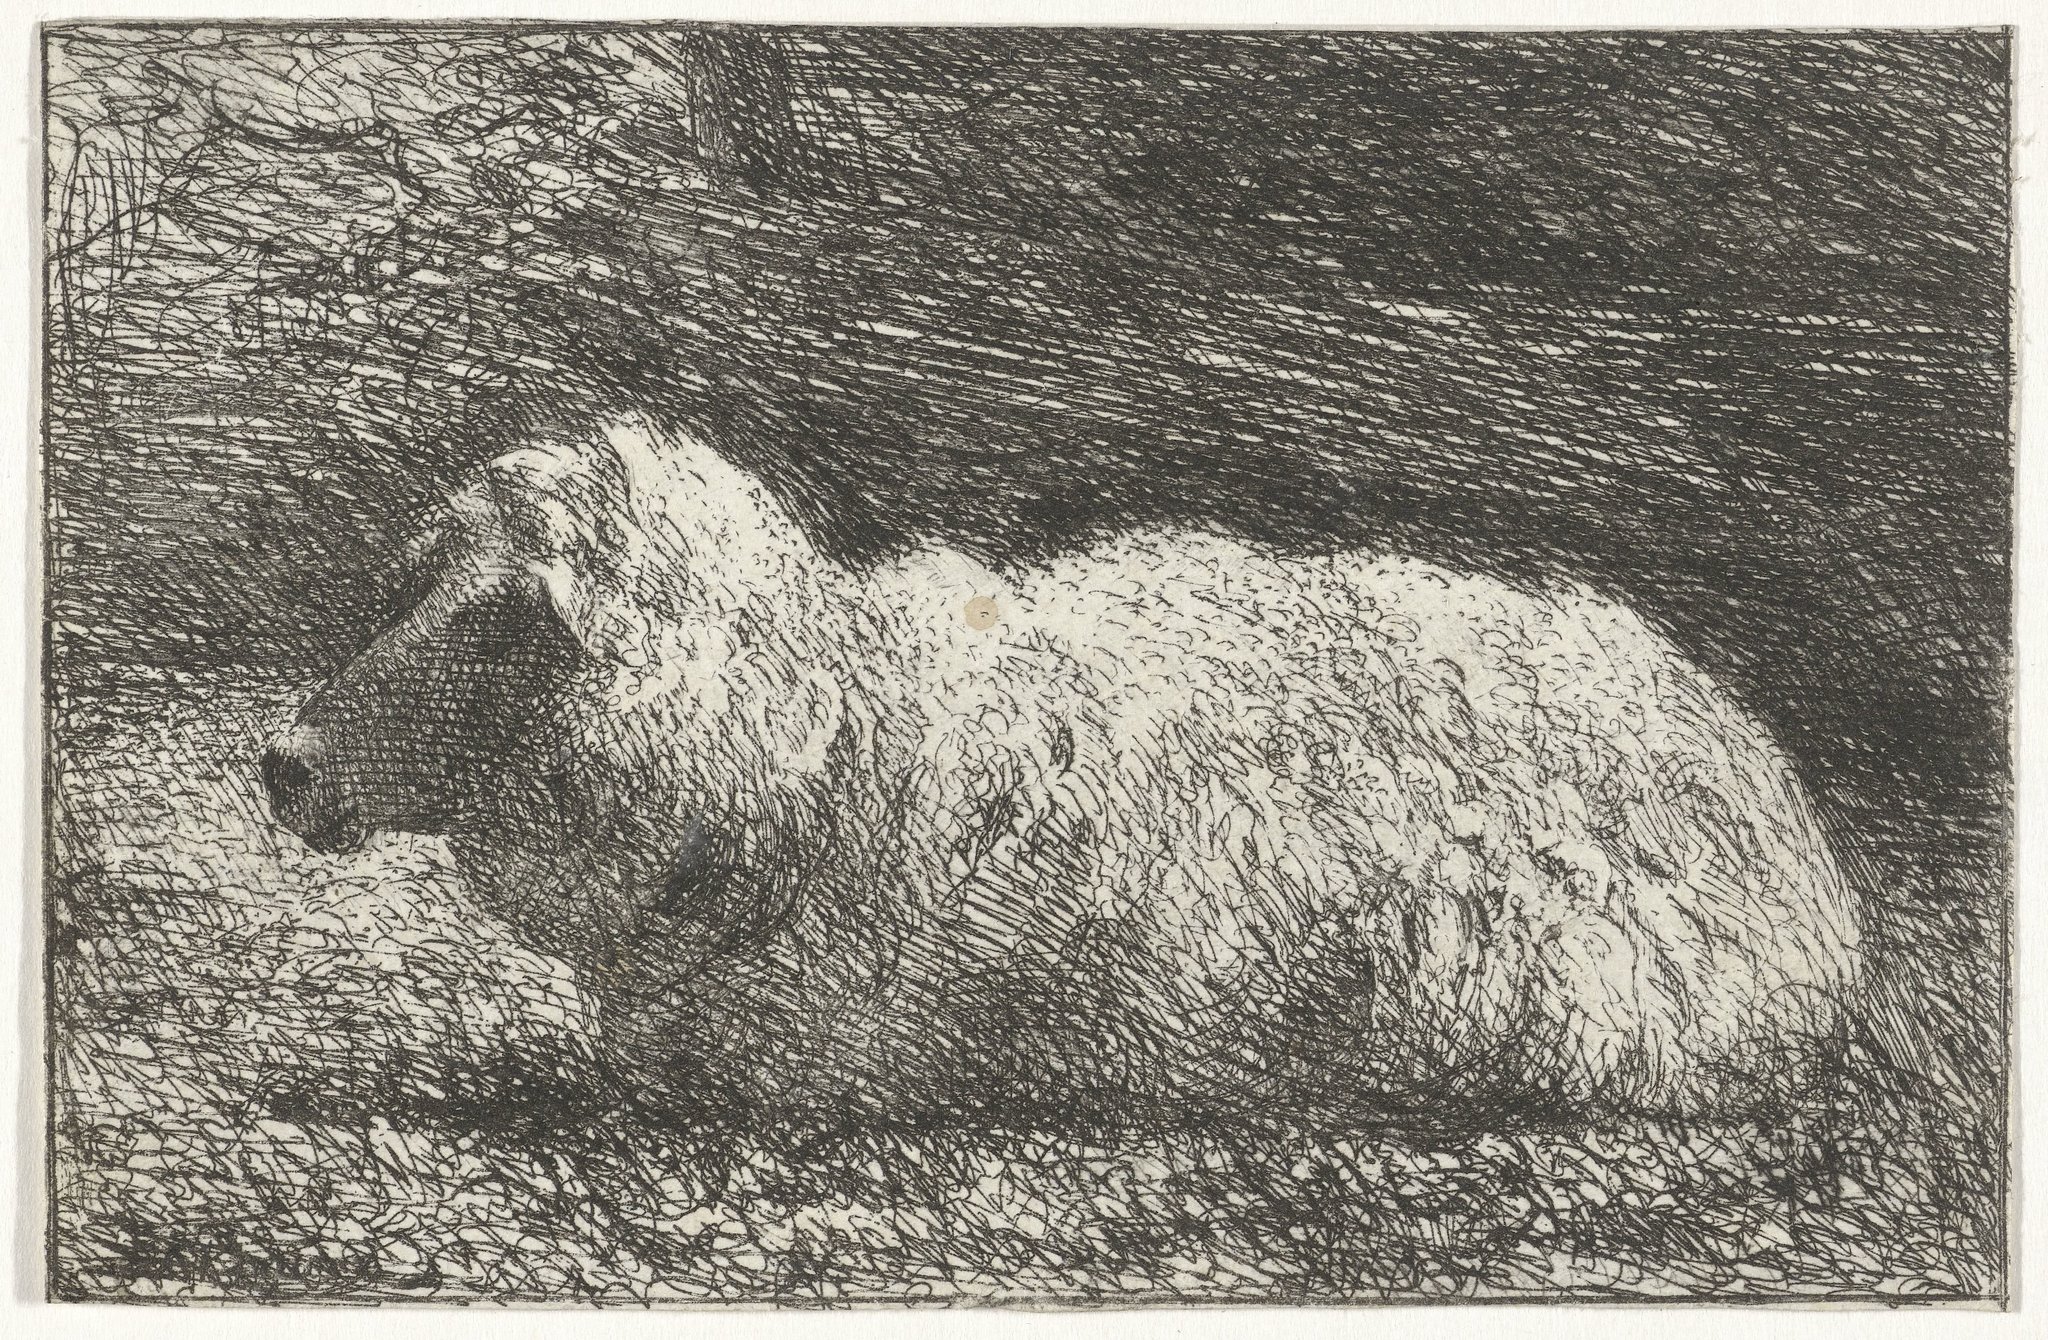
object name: print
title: Liggend schaap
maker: simon andreas krausz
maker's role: draughtsman, print maker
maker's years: 1760-1825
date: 1770-1825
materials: paper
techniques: etching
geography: the hague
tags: sheep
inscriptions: collector's mark: Lugt 2228